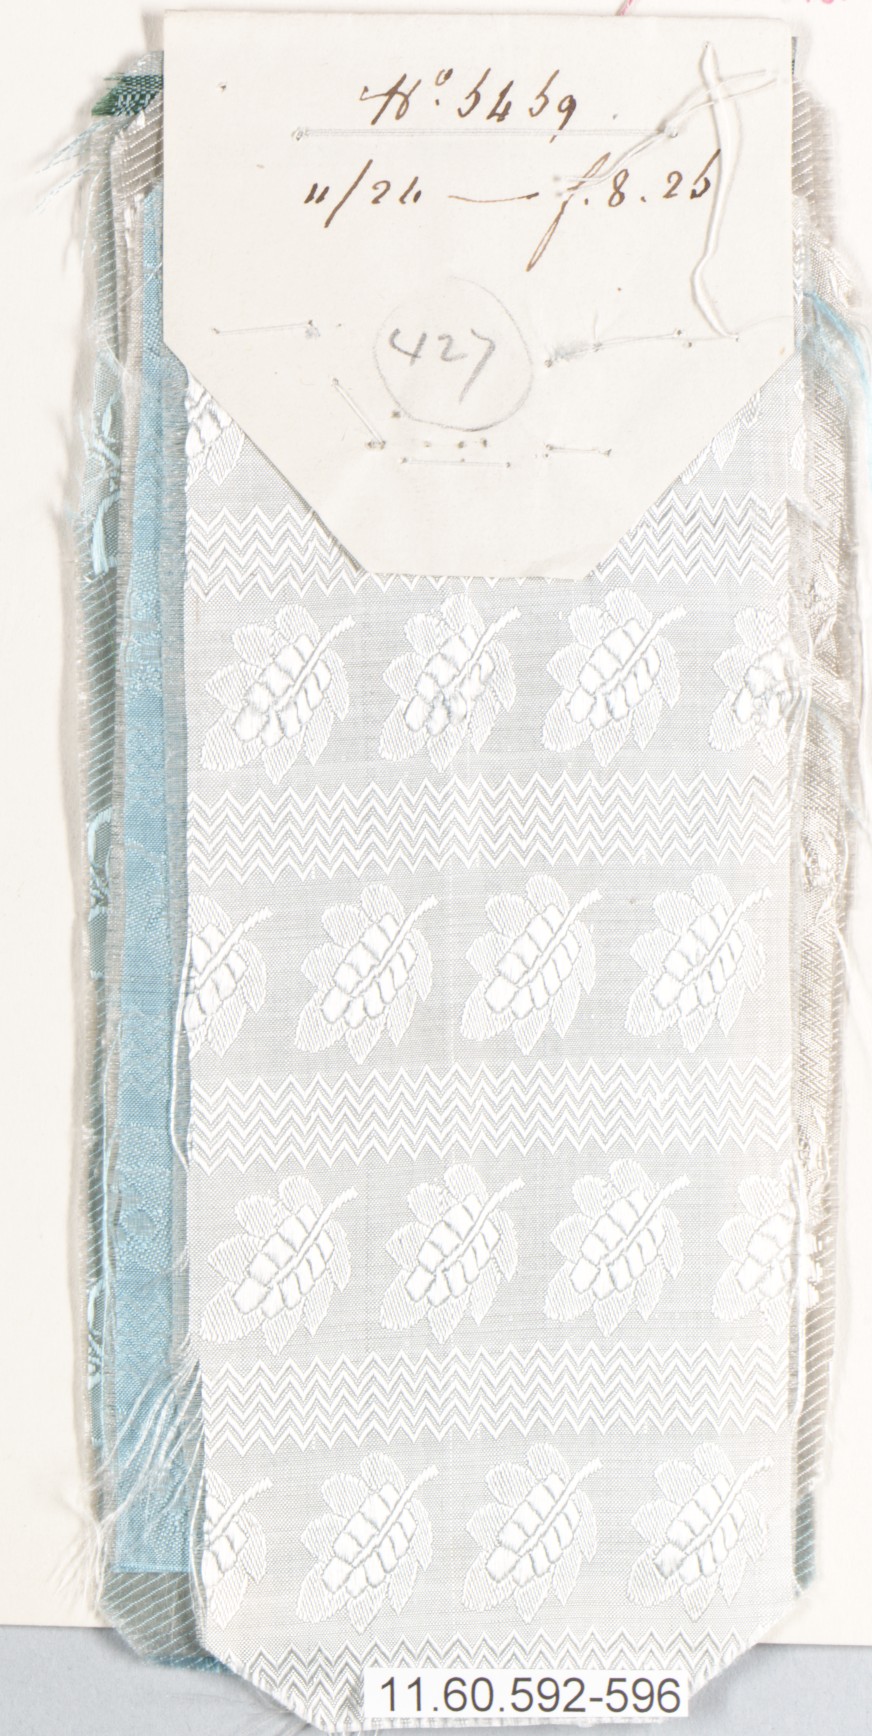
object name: sample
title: Samples (5)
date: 1801-1850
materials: silk